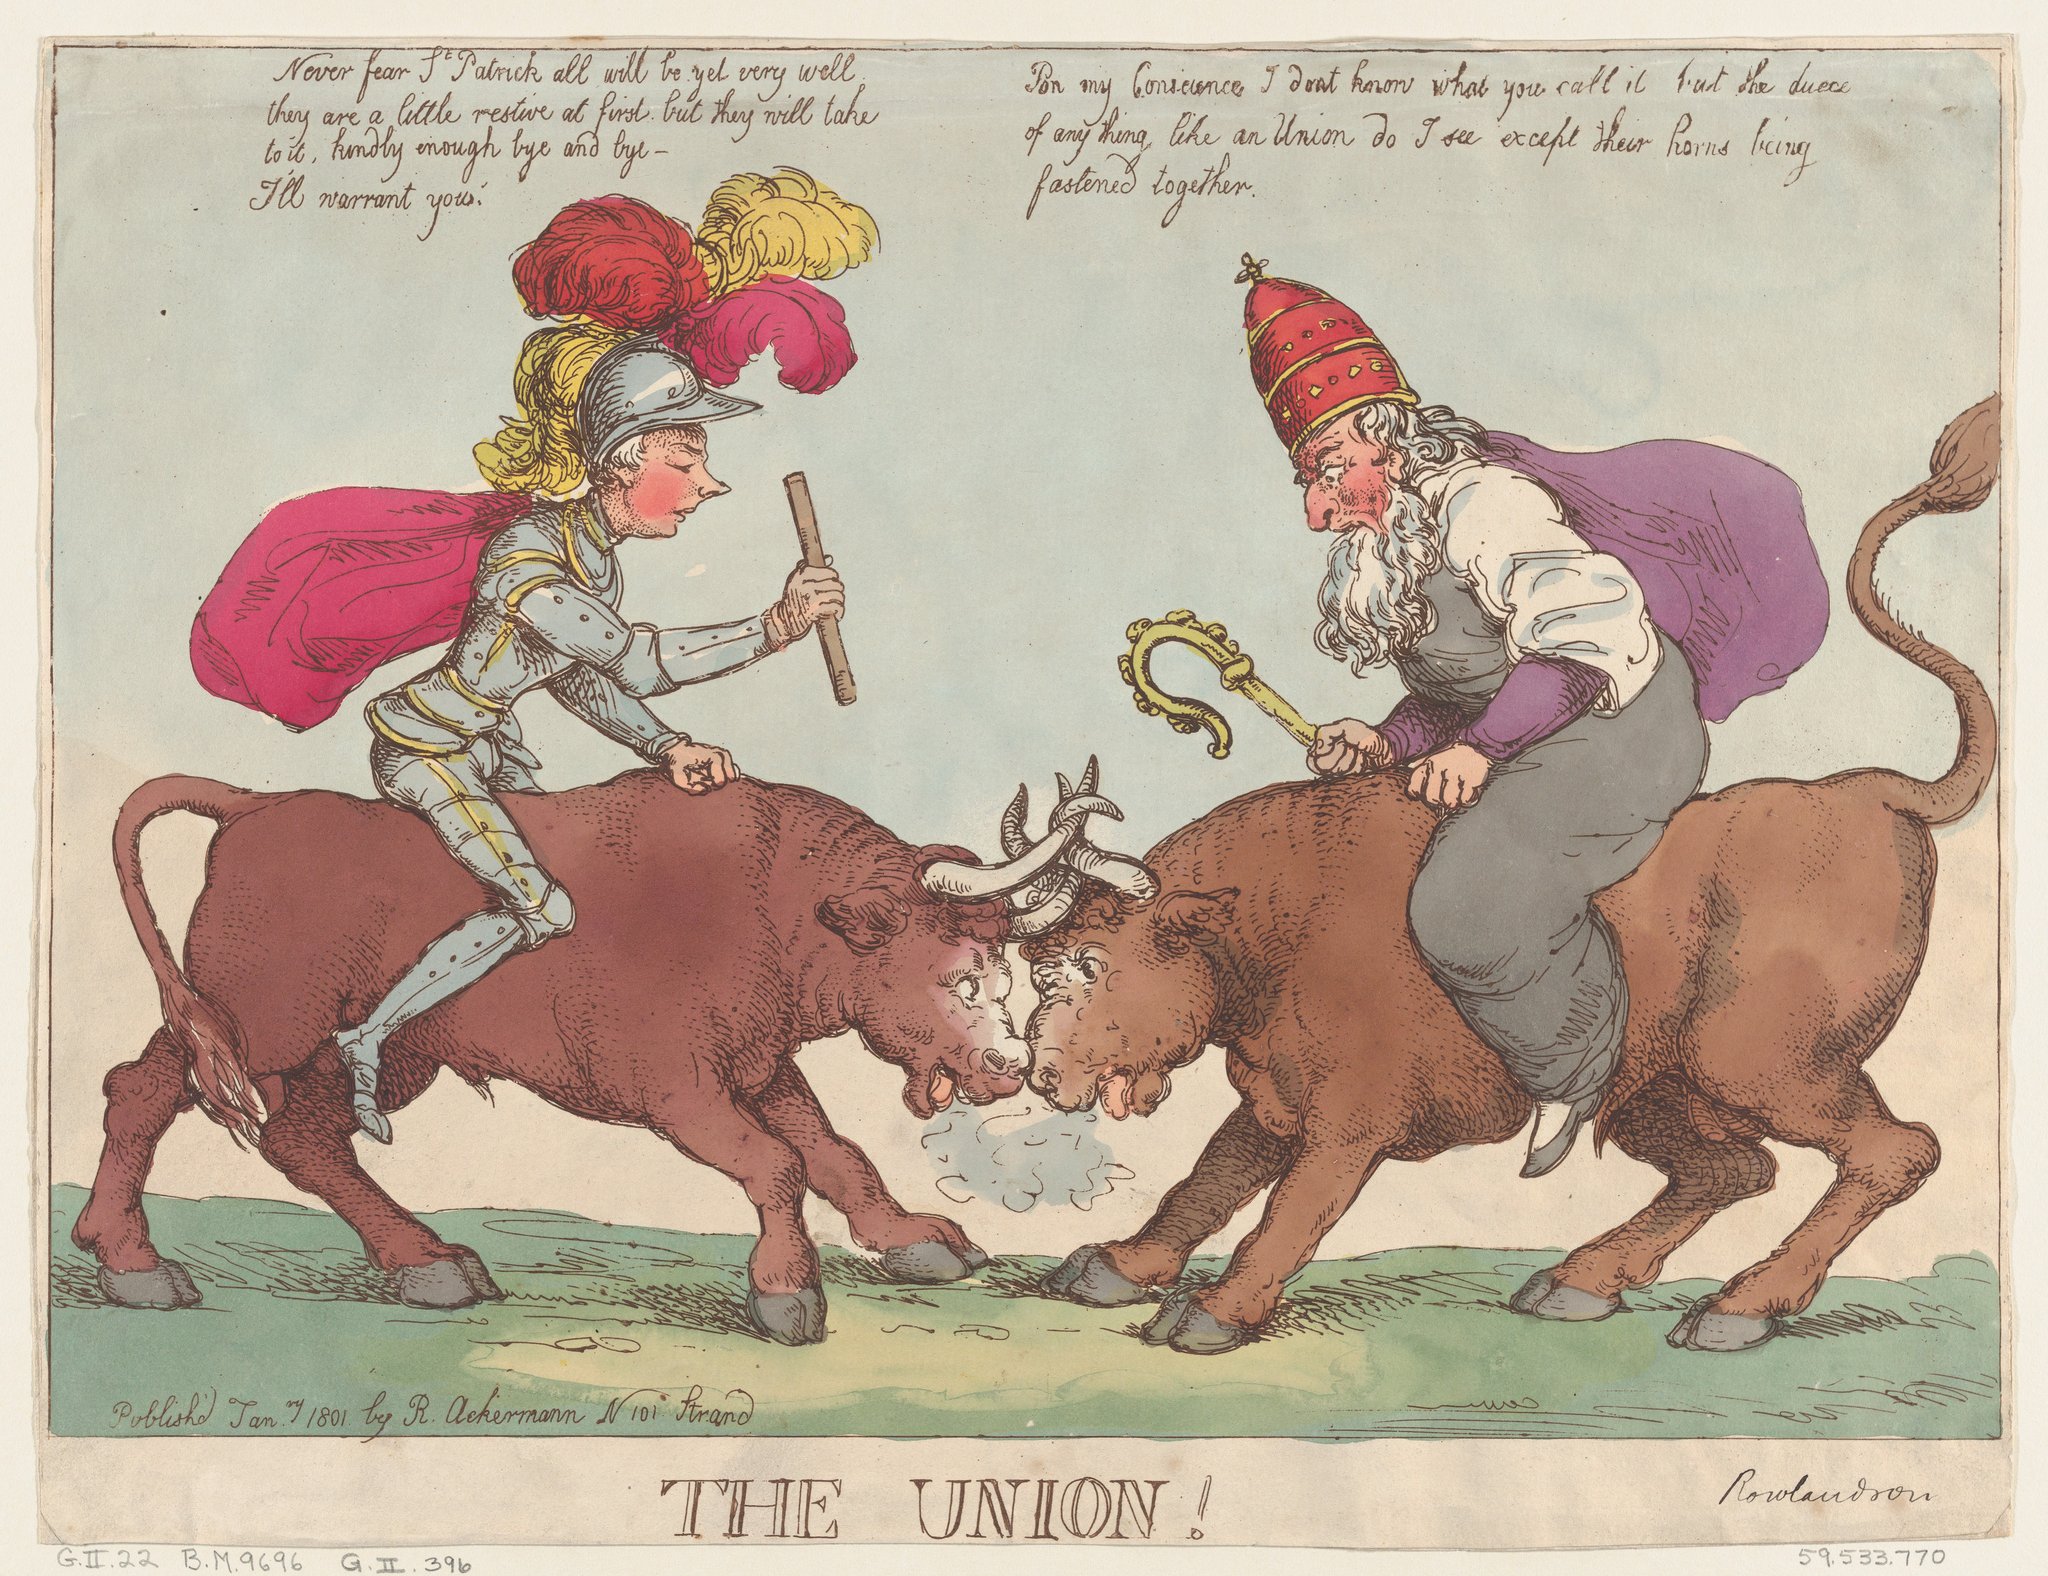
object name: print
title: The Union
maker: thomas rowlandson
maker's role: artist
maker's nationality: british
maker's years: 1757-1827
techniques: etching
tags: satire,men,women,bulls